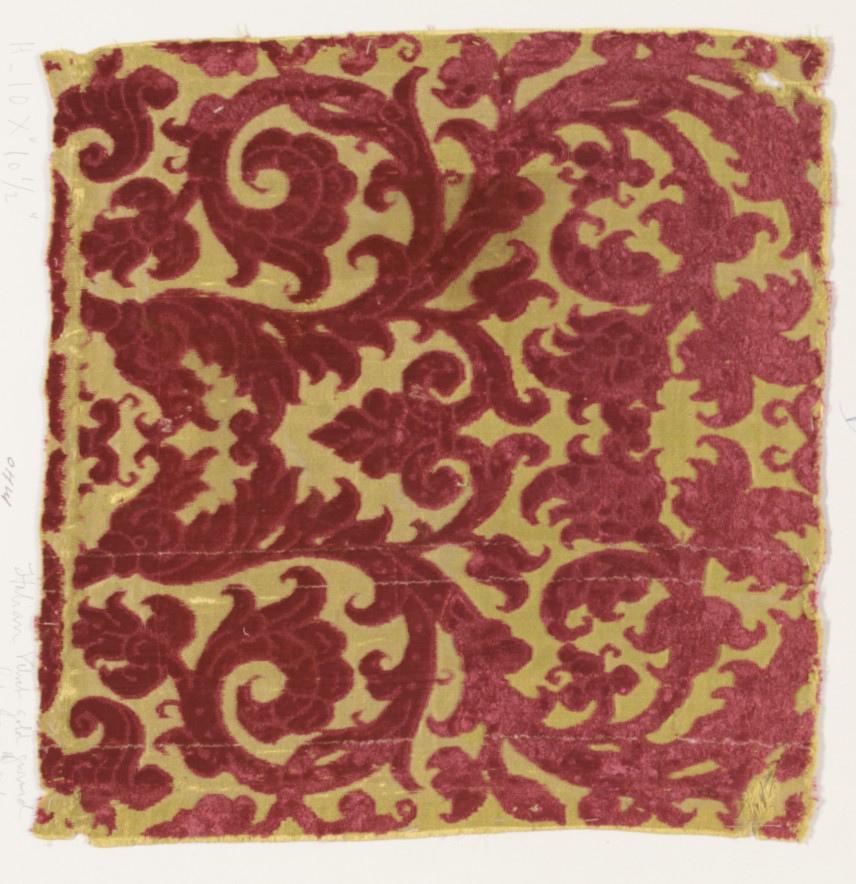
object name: fragment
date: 1567-1600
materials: silk